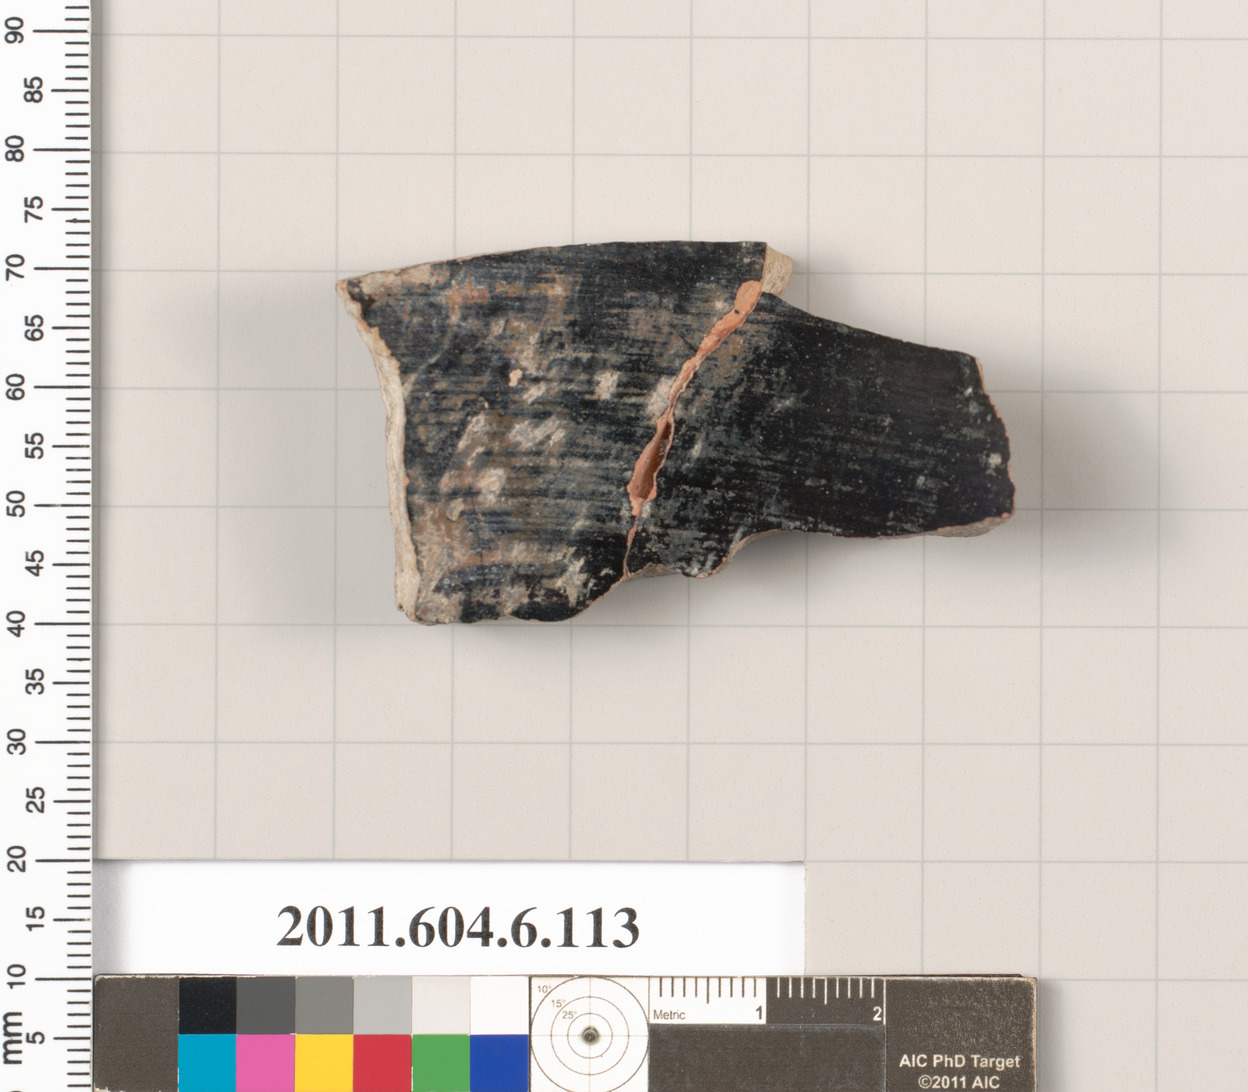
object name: undetermined shape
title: Terracotta fragment of an undetermined shape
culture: greek, attic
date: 600-401 BCE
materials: terracotta